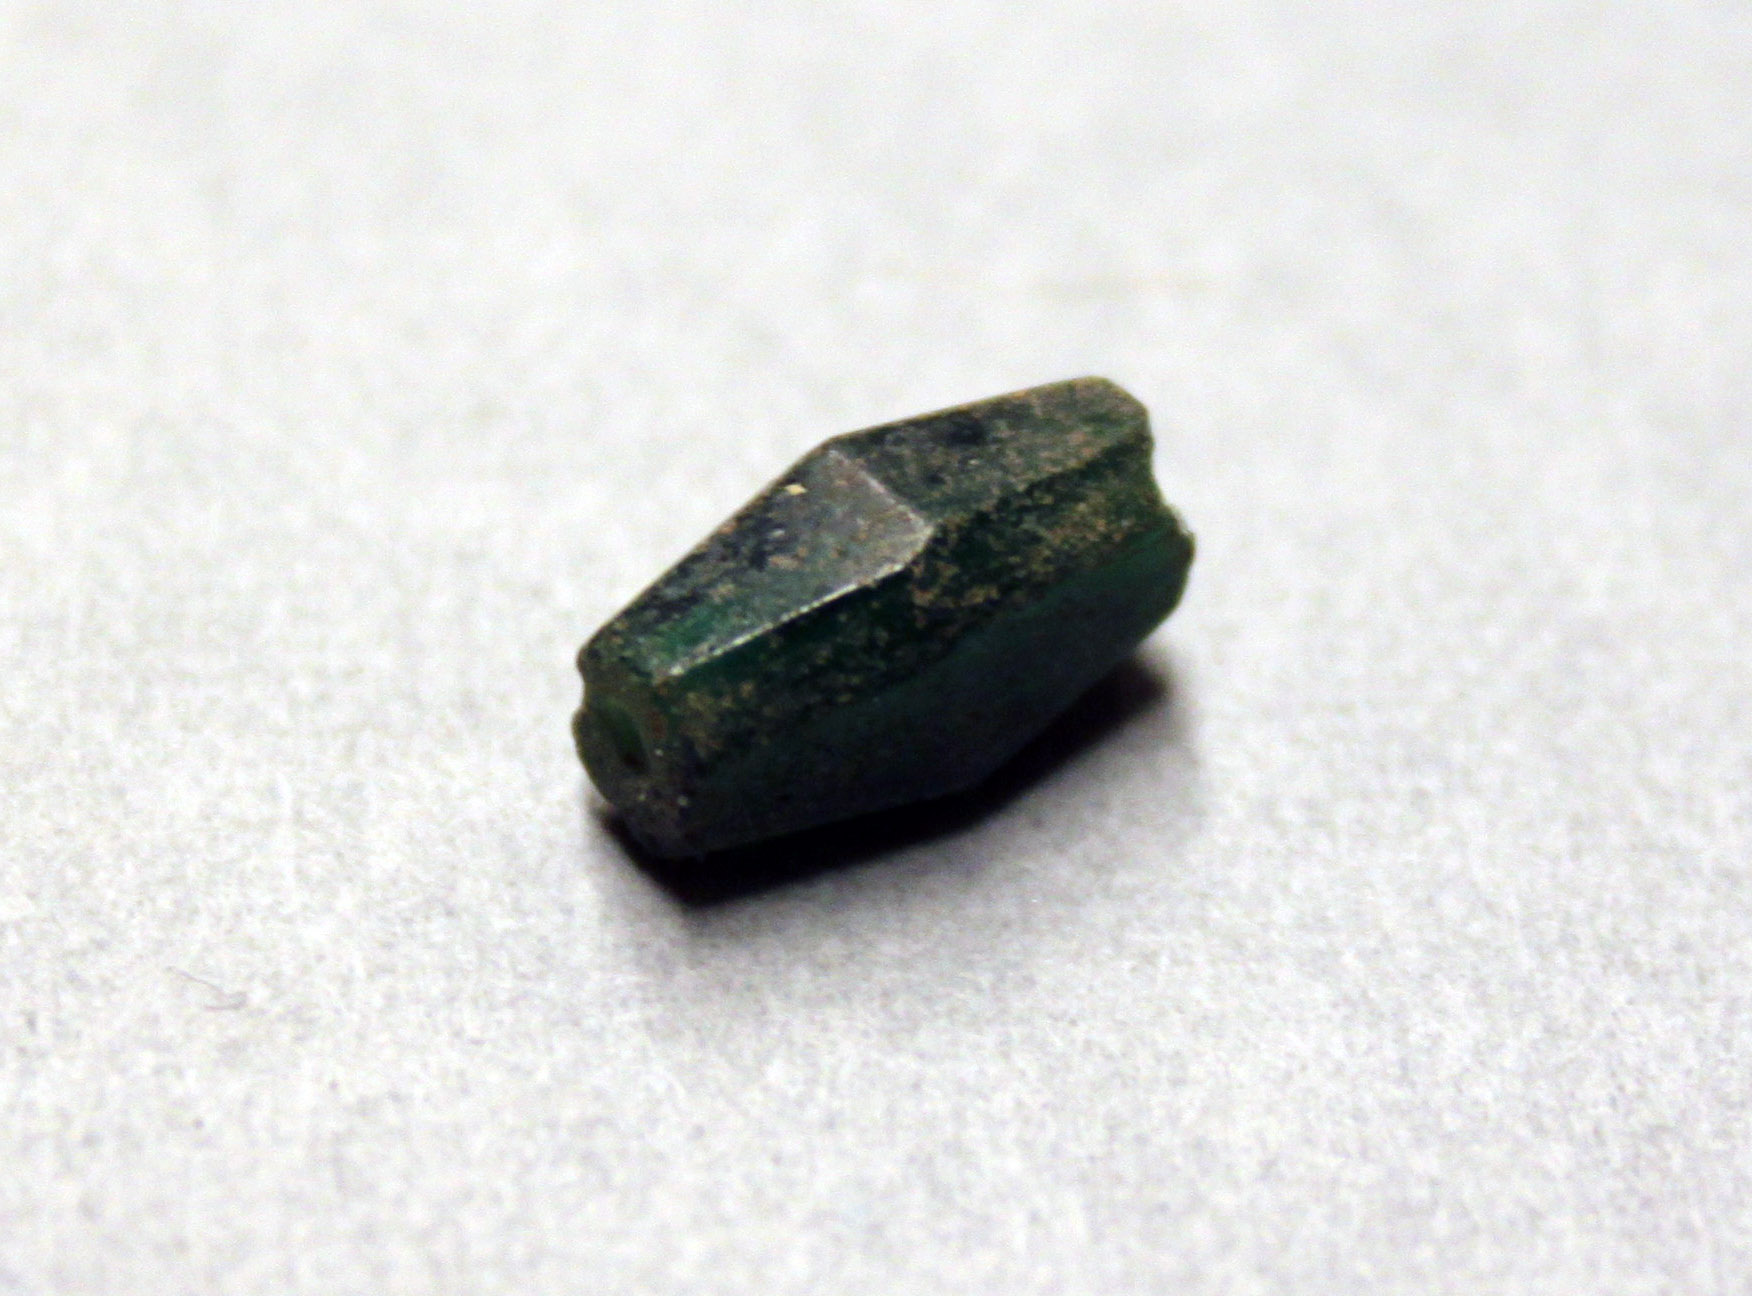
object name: bead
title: Beads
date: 801-1200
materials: glass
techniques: cutting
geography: iran